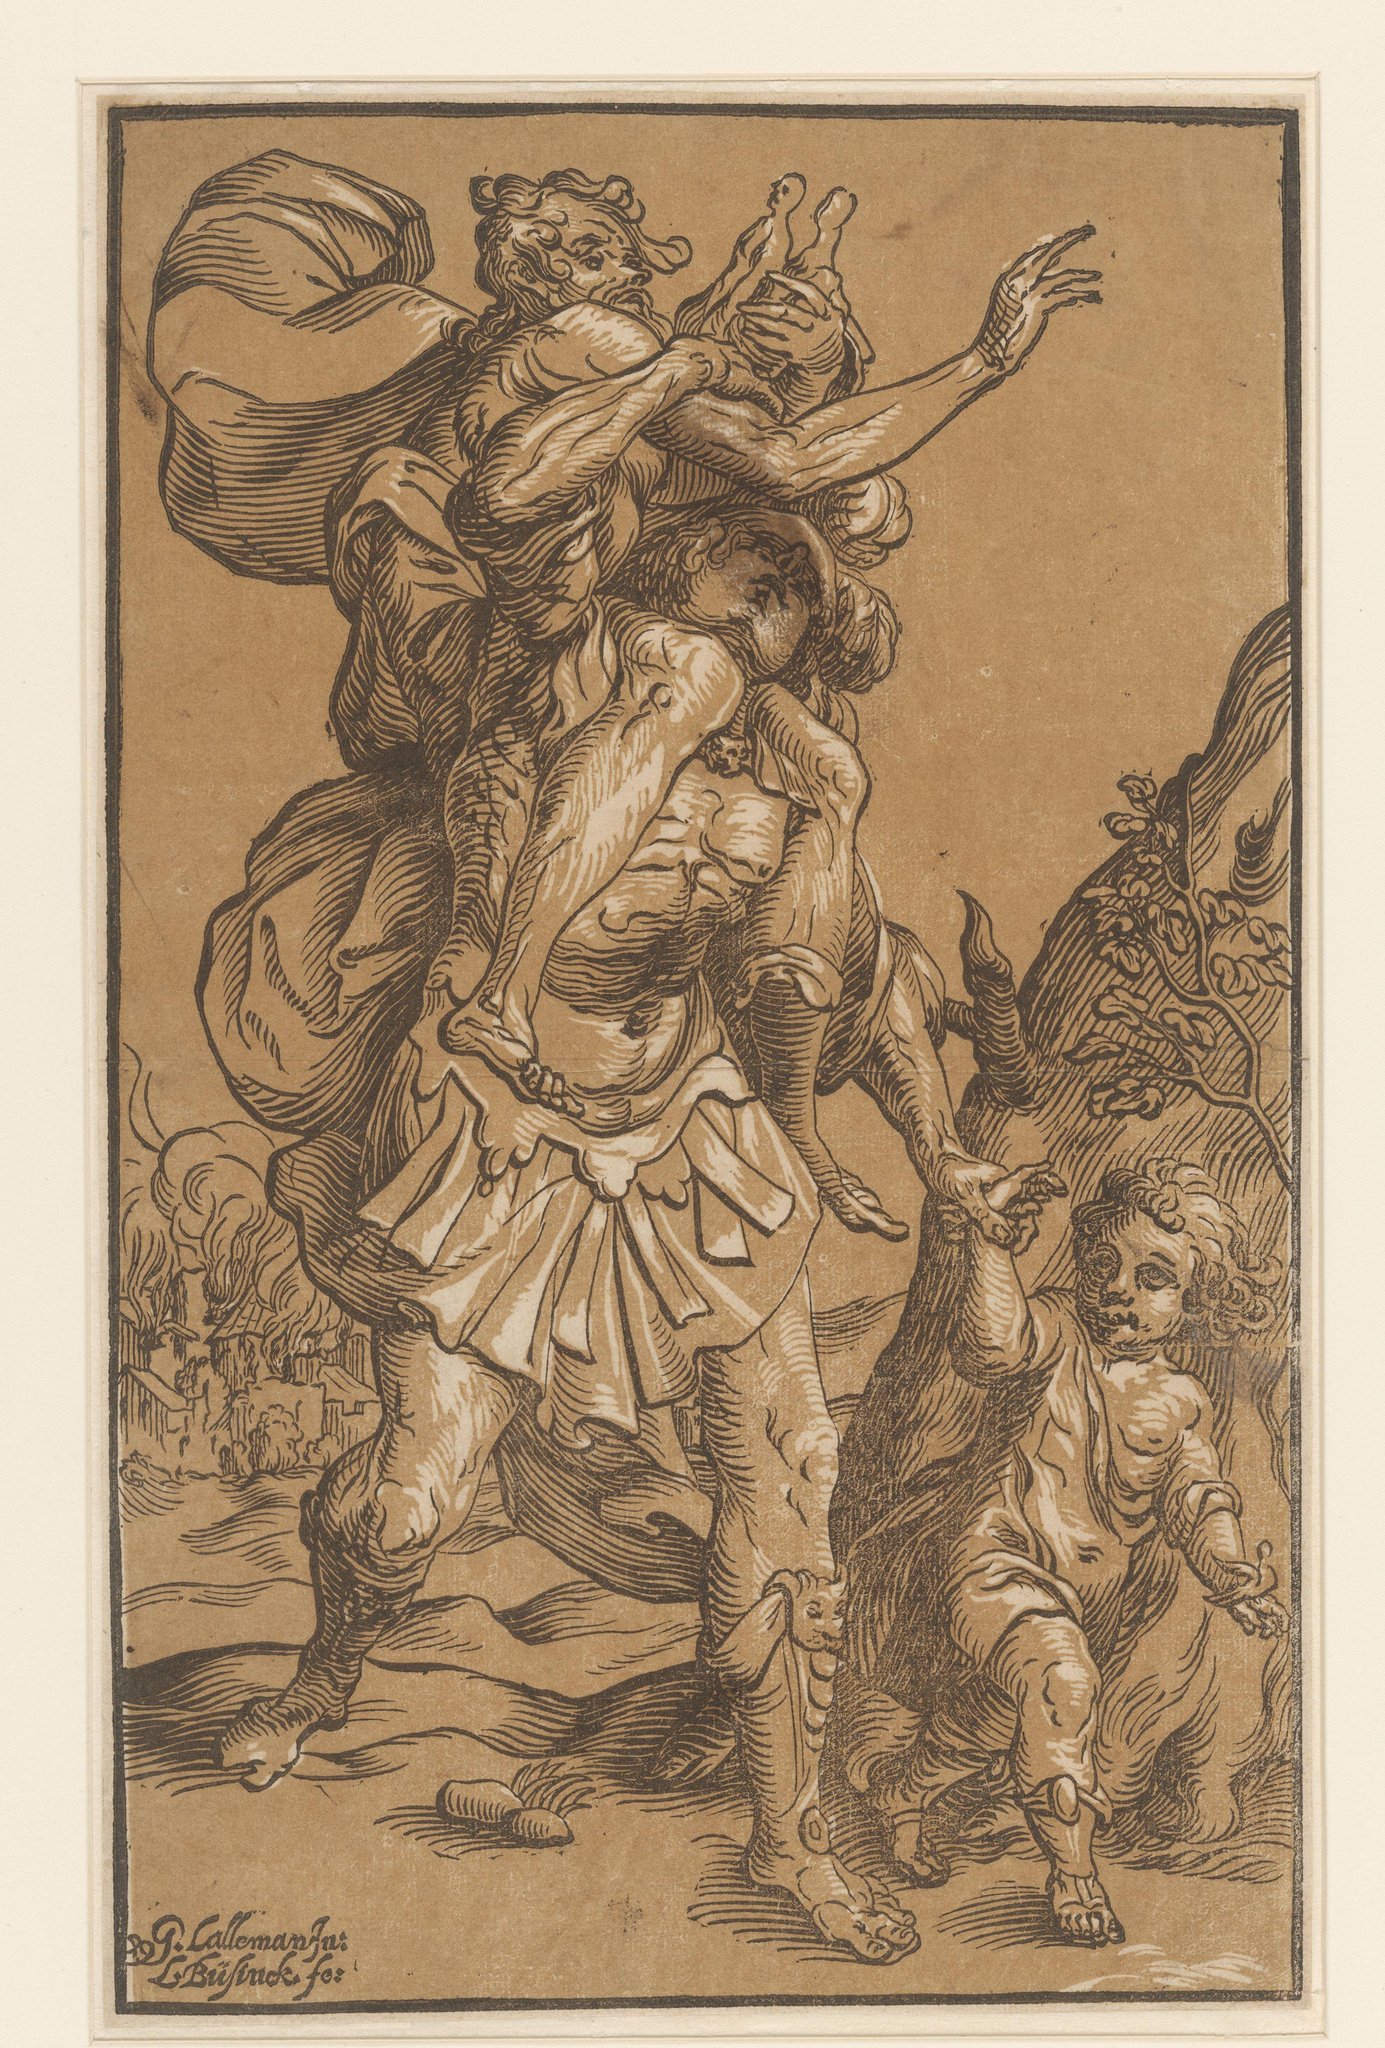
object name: print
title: Aeneas draagt zijn vader uit Troje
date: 1600-1669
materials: paper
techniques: woodcut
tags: 'pius aeneas': aeneas, leading ascanius, escapes from burning troy, carrying his father anchises with the penates; his wife creusa, who sets out with them, is lost on the way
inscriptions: collector's mark: Lugt 2228